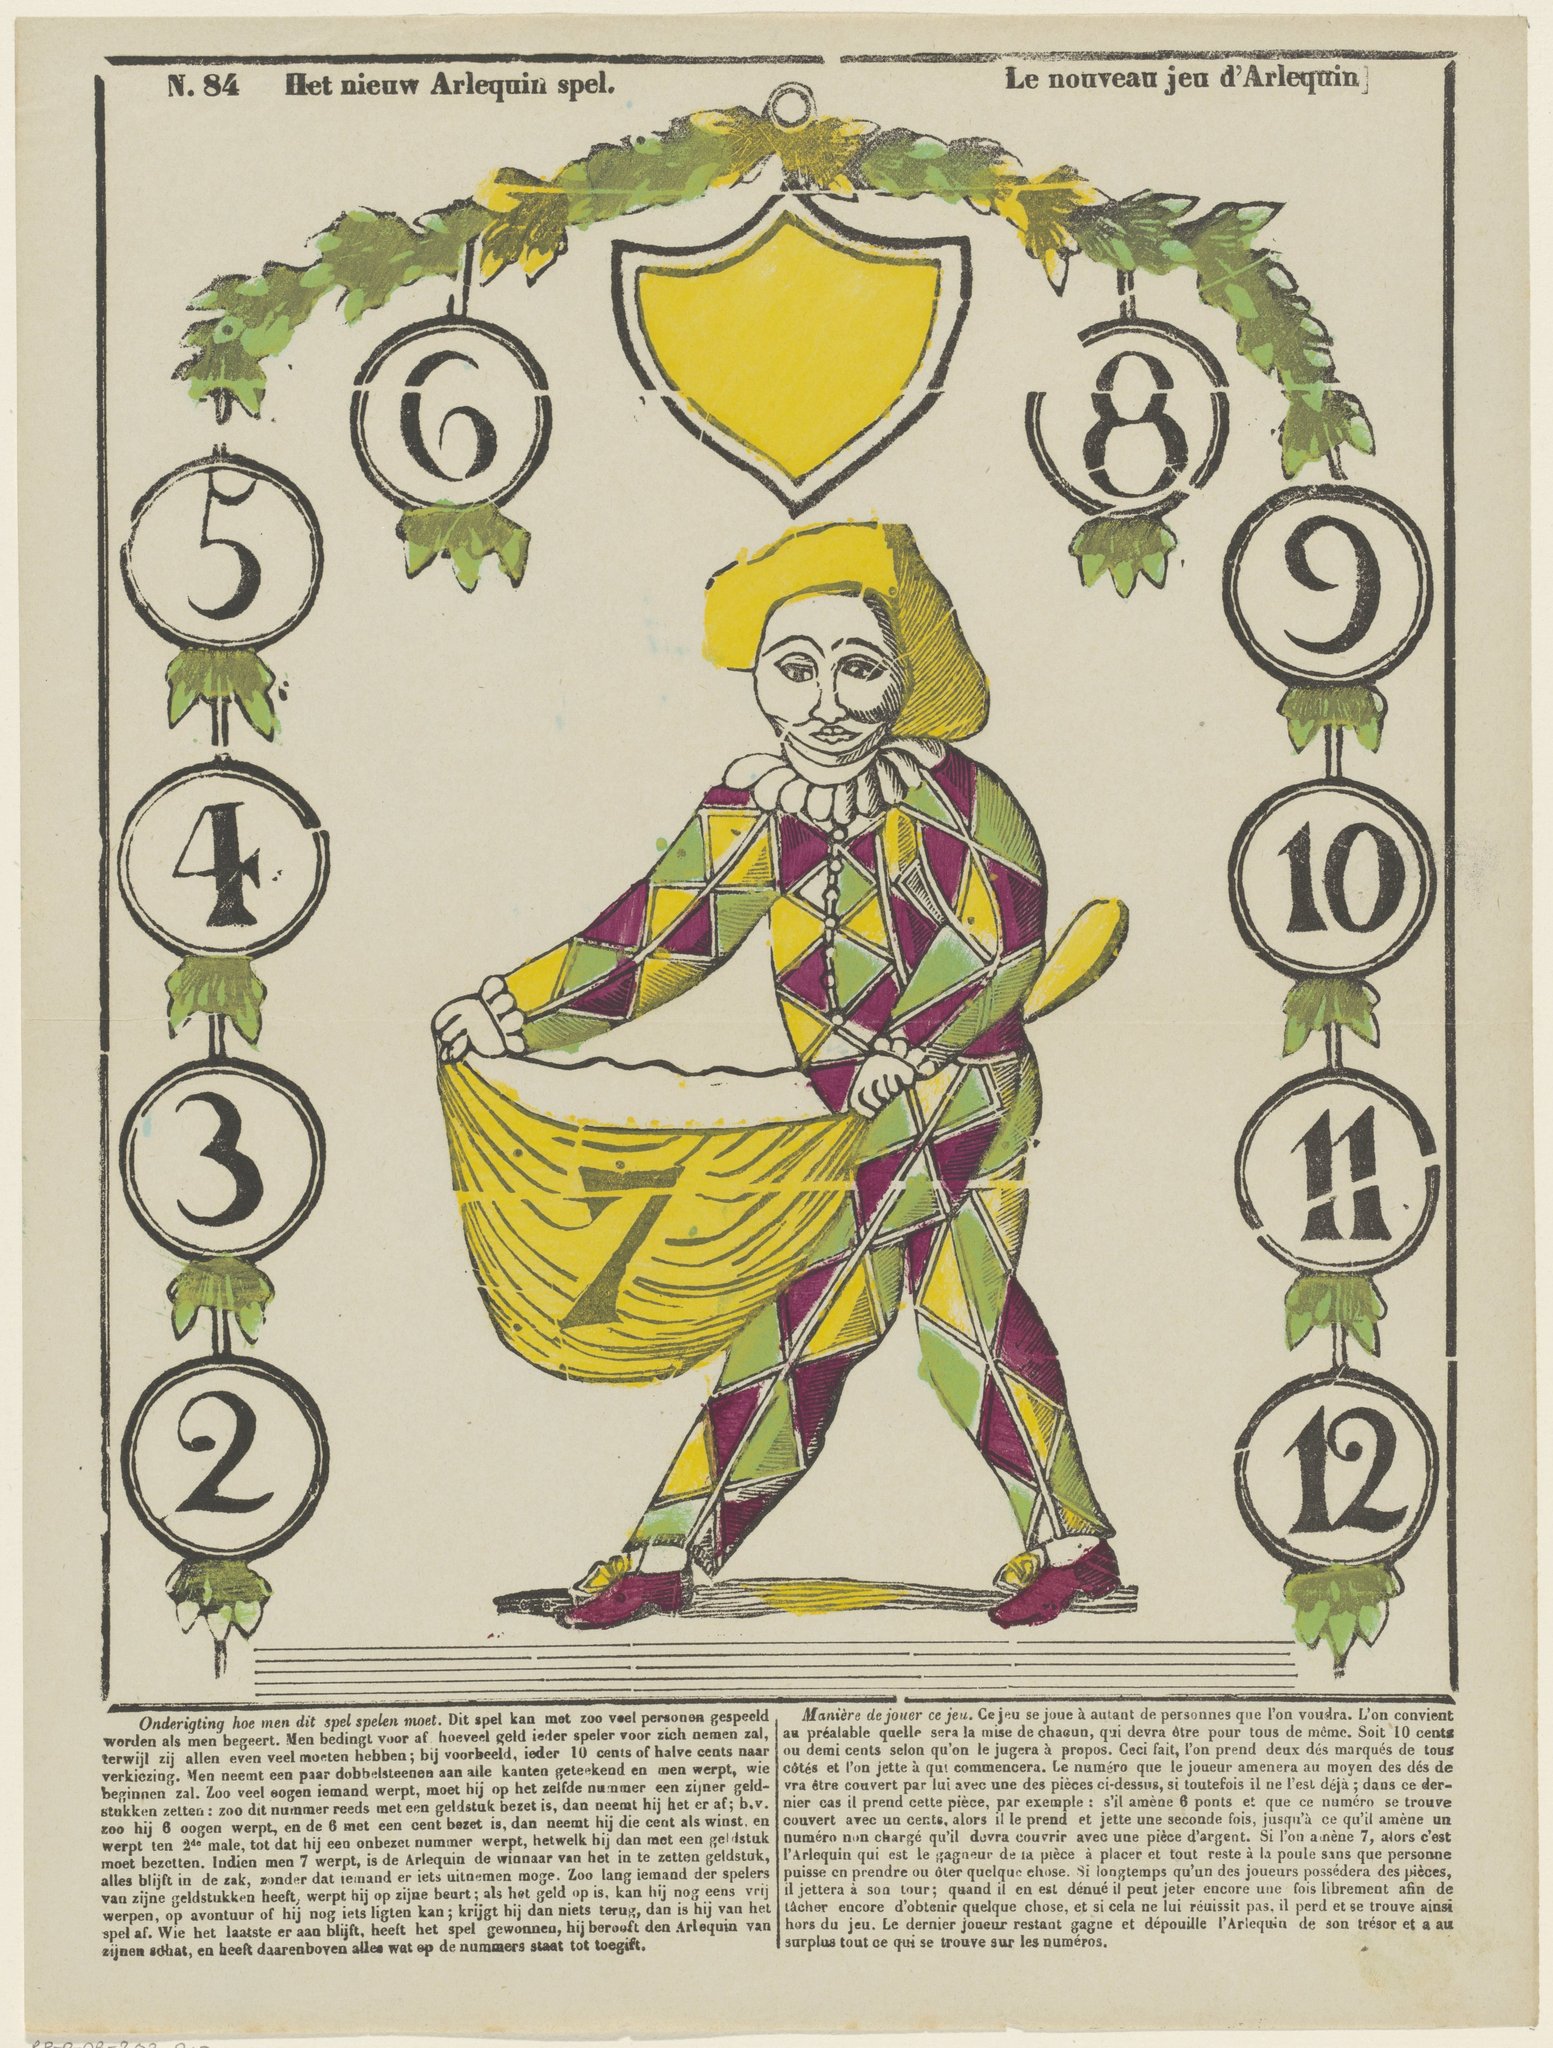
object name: print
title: Het nieuw Arlequin spel / Le nouveau jeu d'Arlequin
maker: Anonymous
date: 1856-1900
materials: paper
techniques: colour, letterpress printing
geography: netherlands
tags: board-games of chance, types in 'commedia dell'arte': harlequin, board-games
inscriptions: collector's mark: Lugt 2760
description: Bordspel met in het midden van het speelveld een harlekijn die in zijn geopende handen een zak houdt met daarop het cijfer 7. Rondom hem een guirlande waaraan medaillons hangen met de cijfers 2 tot en met 12. Bovenaan in het midden een schild. Onder de voorstelling de spelregels in het Nederlands en in het Frans in twee kolommen. Genummerd linksboven: No. 84.